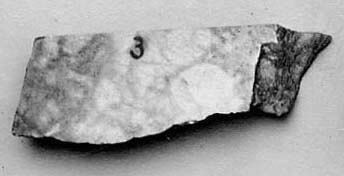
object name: fragment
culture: burmese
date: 1902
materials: jade